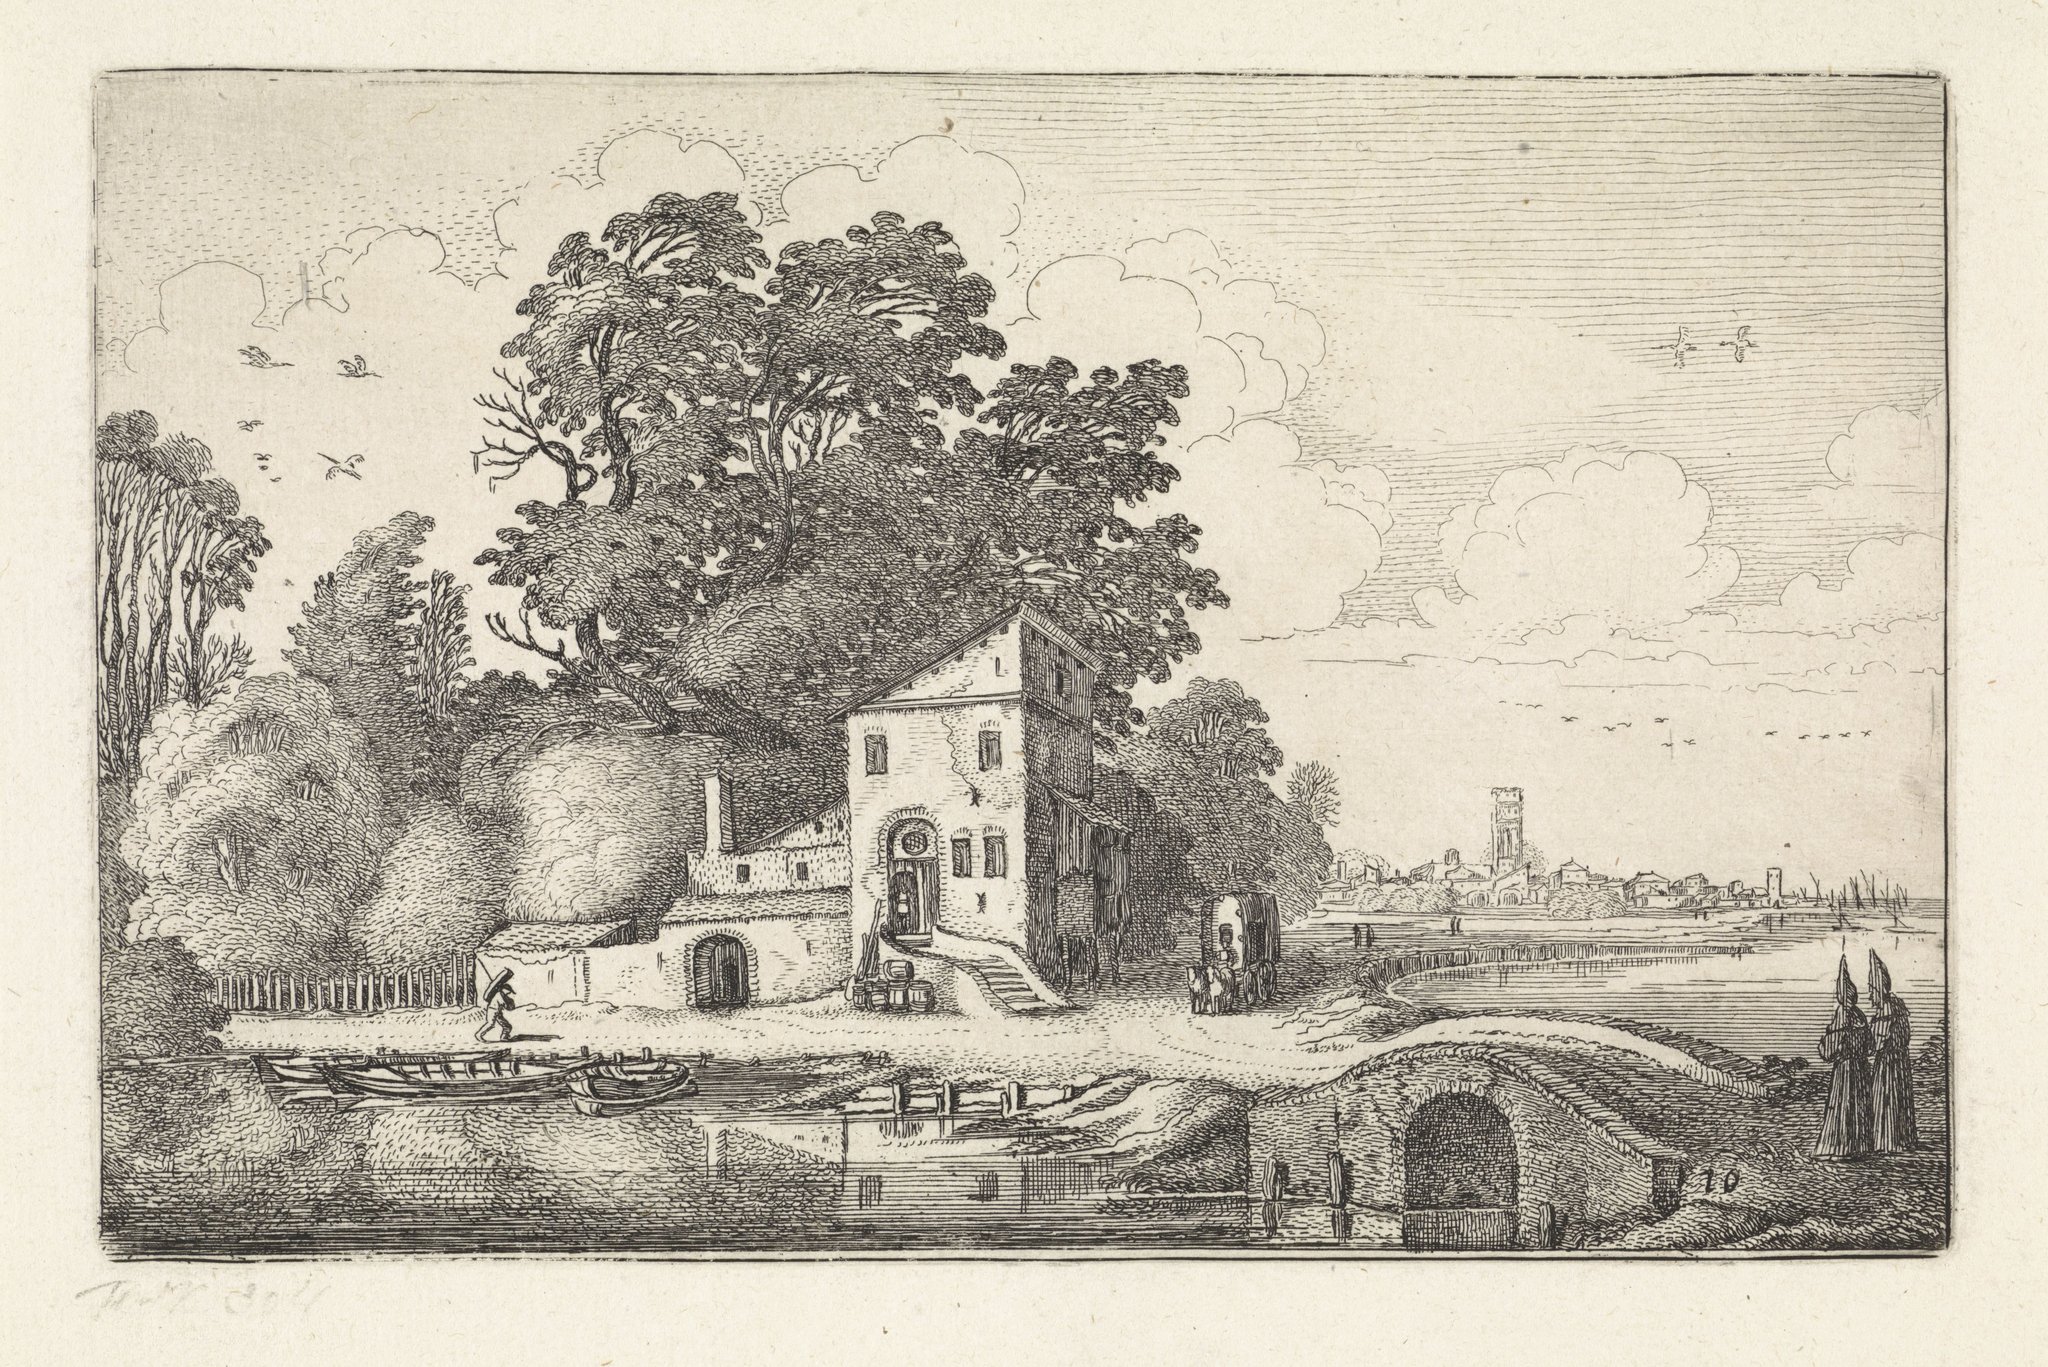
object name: print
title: Amenissimae aliquot requculae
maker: jan van de velde (ii)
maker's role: draughtsman, painter, print maker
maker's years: 1593-1641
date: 1616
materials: paper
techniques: etching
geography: northern netherlands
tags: city-view, and landscape with man-made constructions, river, landscape with bridge, viaduct or aqueduct, covered wagon, hooded wagon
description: Een man en een huifkar bij een huis langs een rivier met een stenen brug. Rechts op de voorgrond twee kloosterlingen en aan de horizon een stad. Tiende prent van deel twee van een serie van in totaal 52 prenten met landschappen, verdeeld over twee delen van elk 26 prenten.